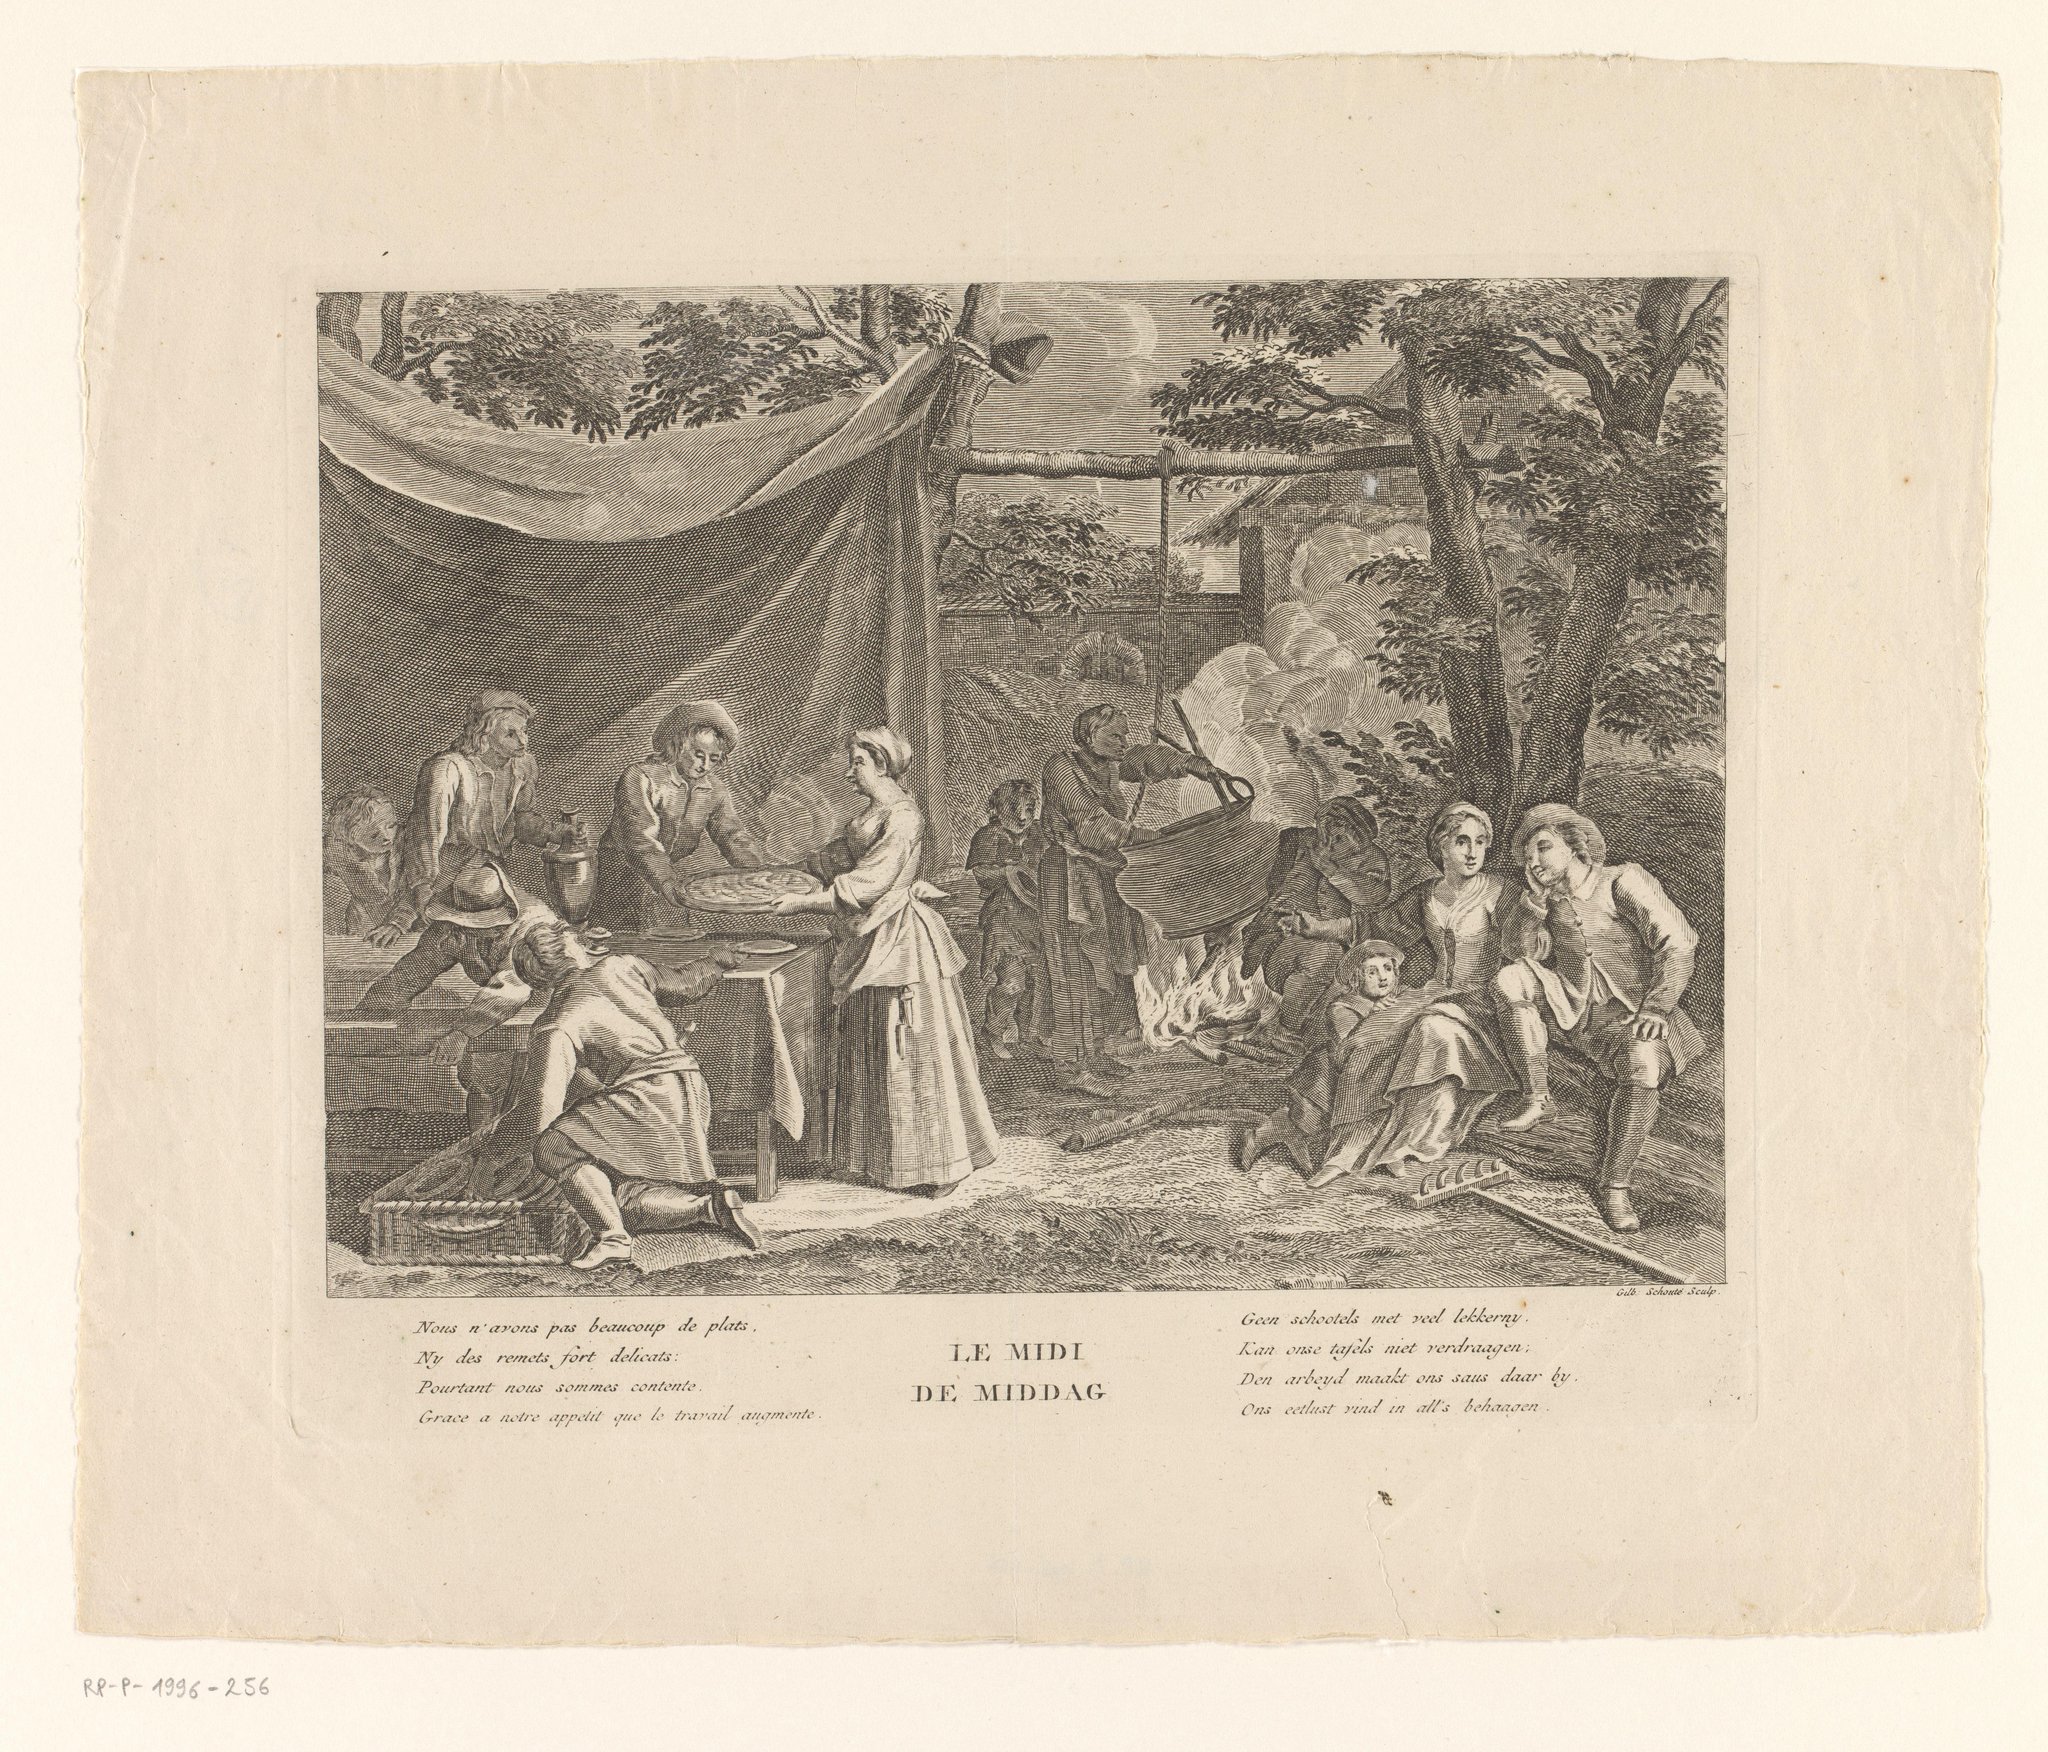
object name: print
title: Le Midi / De middag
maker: gilbert schouten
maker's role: print maker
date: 1706-1720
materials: paper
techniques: engraving, etching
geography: netherlands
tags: midday meal, lunch - cc - out of doors, afternoon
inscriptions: inscription: ‘J.D’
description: Links wordt een tafel gedekt. Centraal een vrouw die in een pot roert. Rechts een vrouw, man en kind. Naast hen ligt een hark. Onder een vierregelig vers in het Frans en Nederlands.